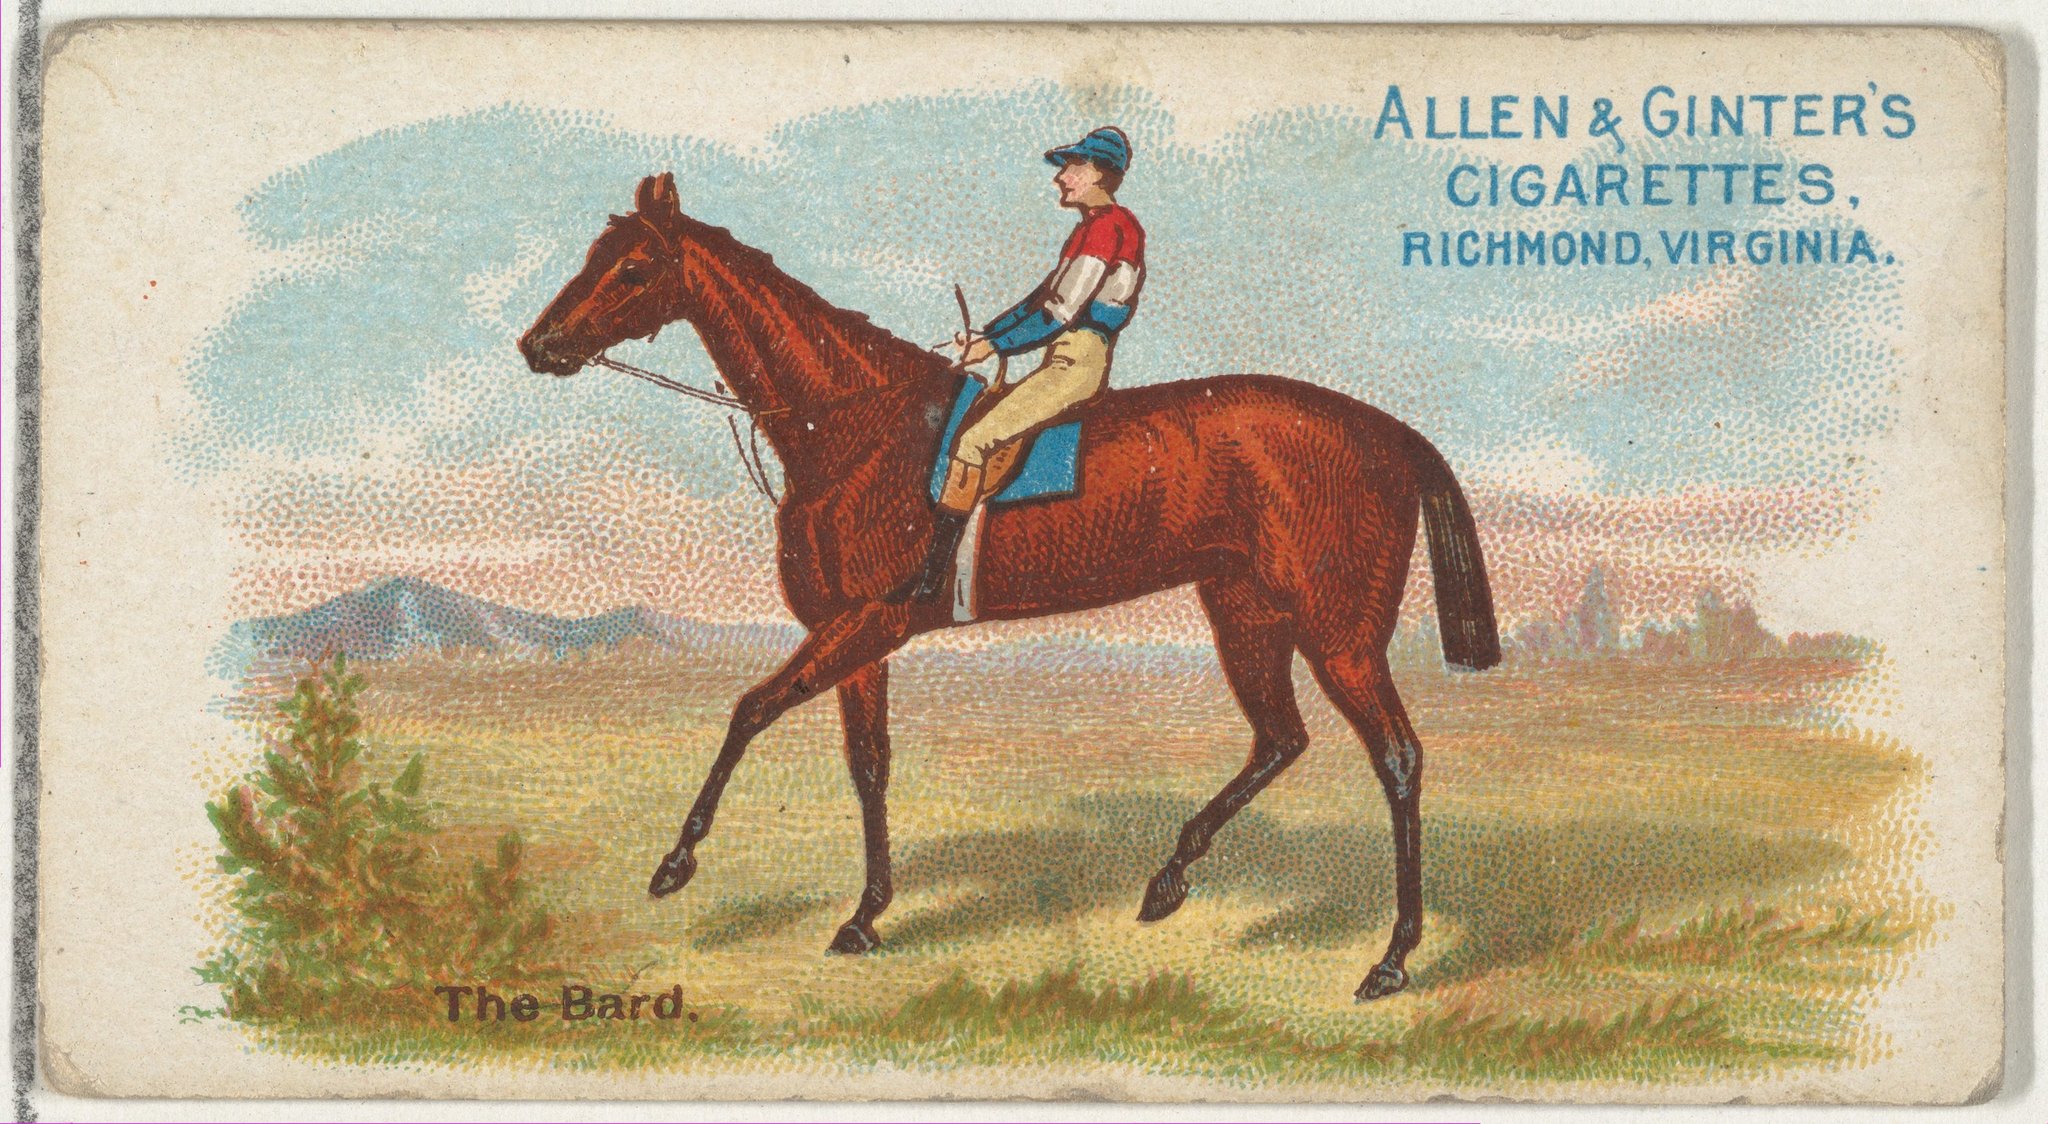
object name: print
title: The Bard, from The World's Racers series (N32) for Allen & Ginter Cigarettes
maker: allen & ginter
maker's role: publisher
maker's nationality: american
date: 1888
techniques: color lithograph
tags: men,horses,jockeys